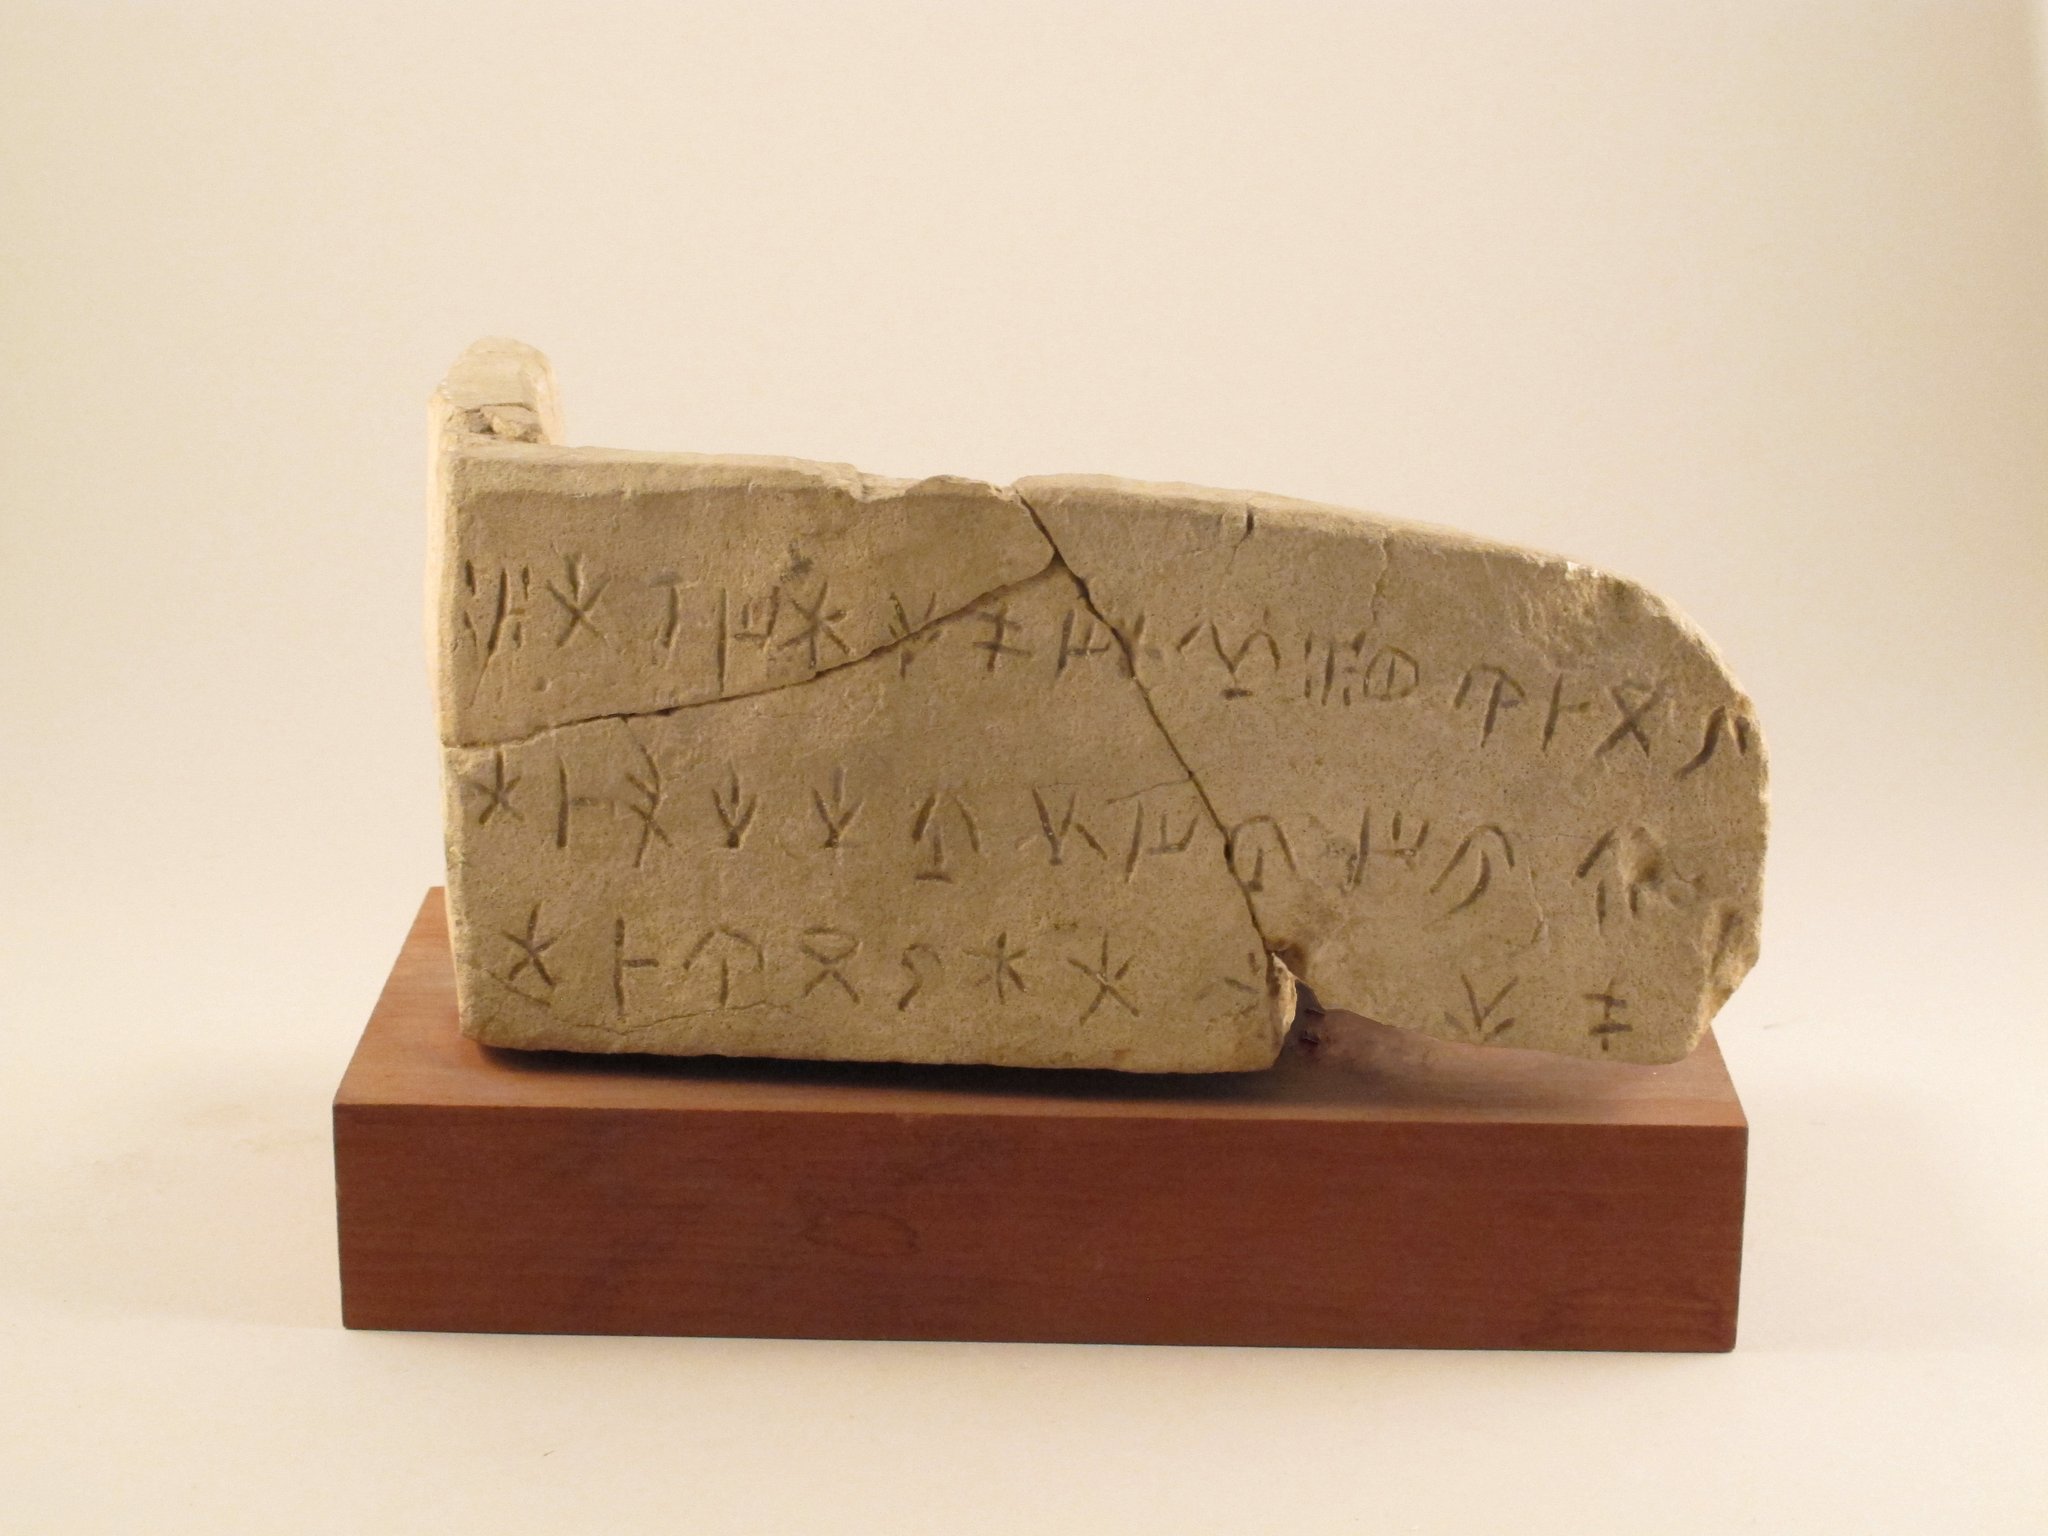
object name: box, inscribed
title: Limestone inscribed box fragment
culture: cypriot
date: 3900 BCE-100 CE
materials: stone